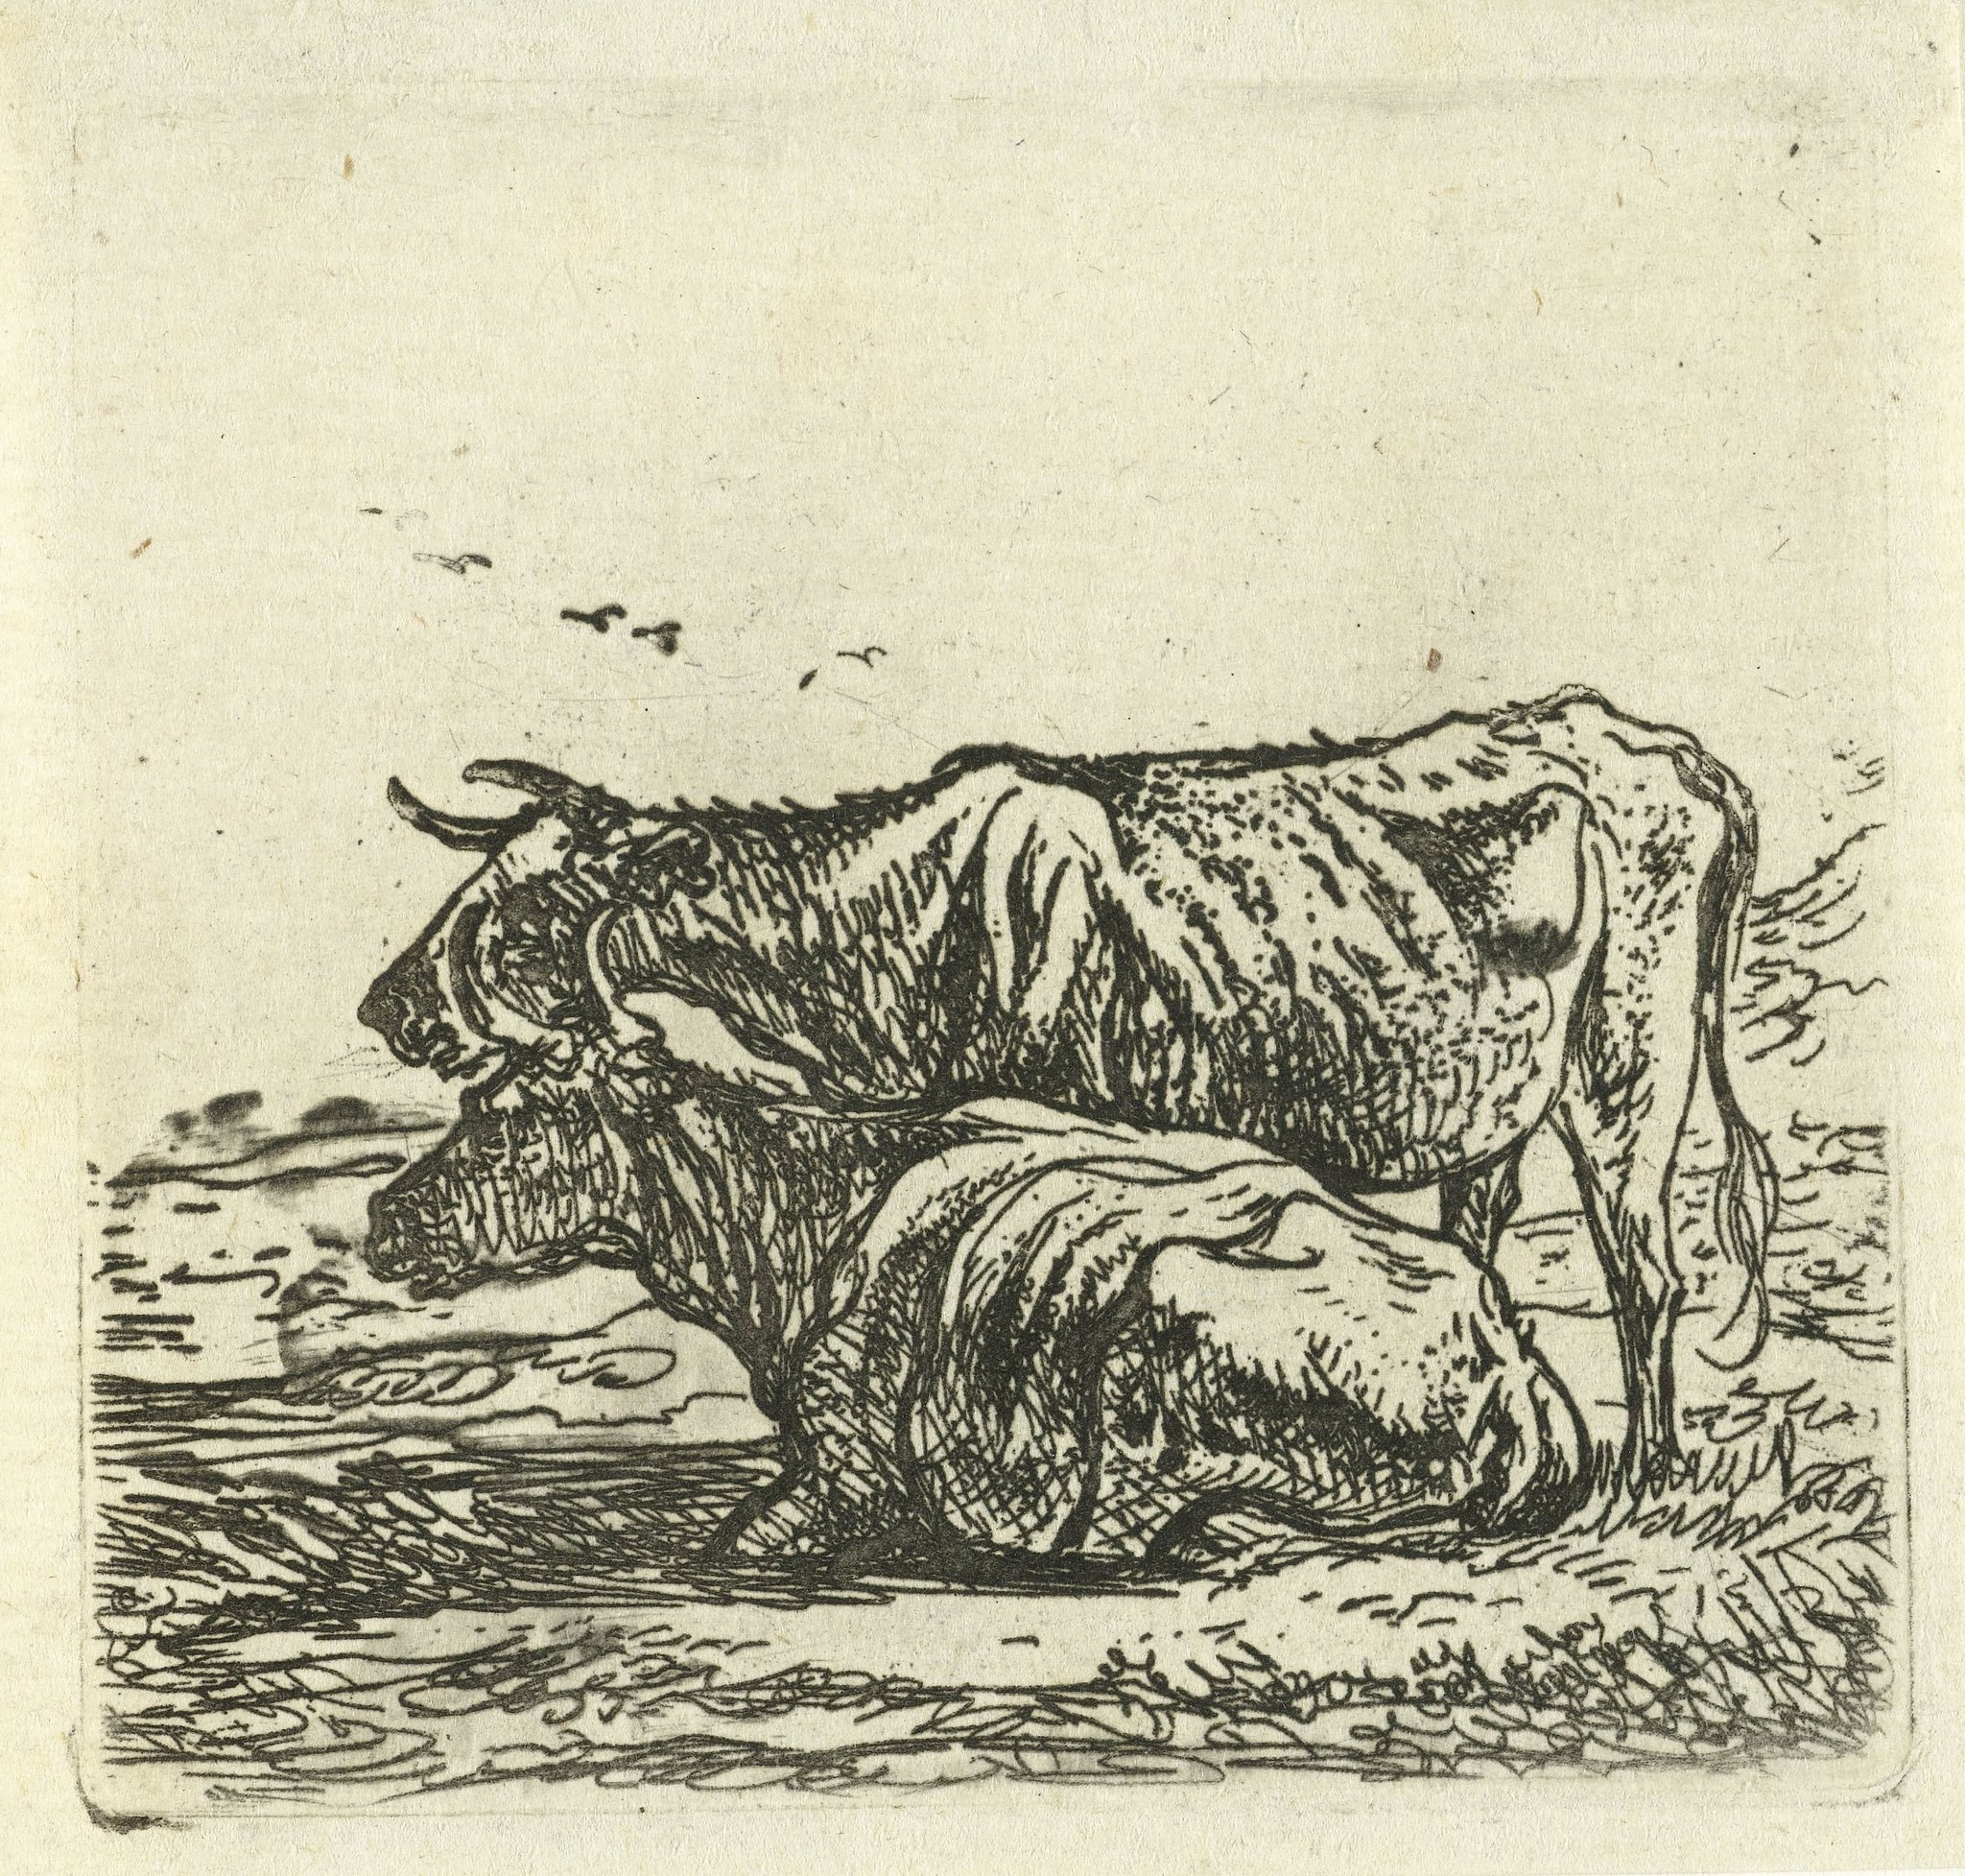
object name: print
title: Koeien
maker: aelbert cuyp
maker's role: draughtsman, painter, print maker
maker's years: 1620-1691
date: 1630-1691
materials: paper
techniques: etching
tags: cow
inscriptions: collector's mark: Lugt 2228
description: Prent uit serie van zes prenten met koeien. Bij de derde staat werd door een anonieme vervaardiger een titelprent aan de serie toegevoegd.